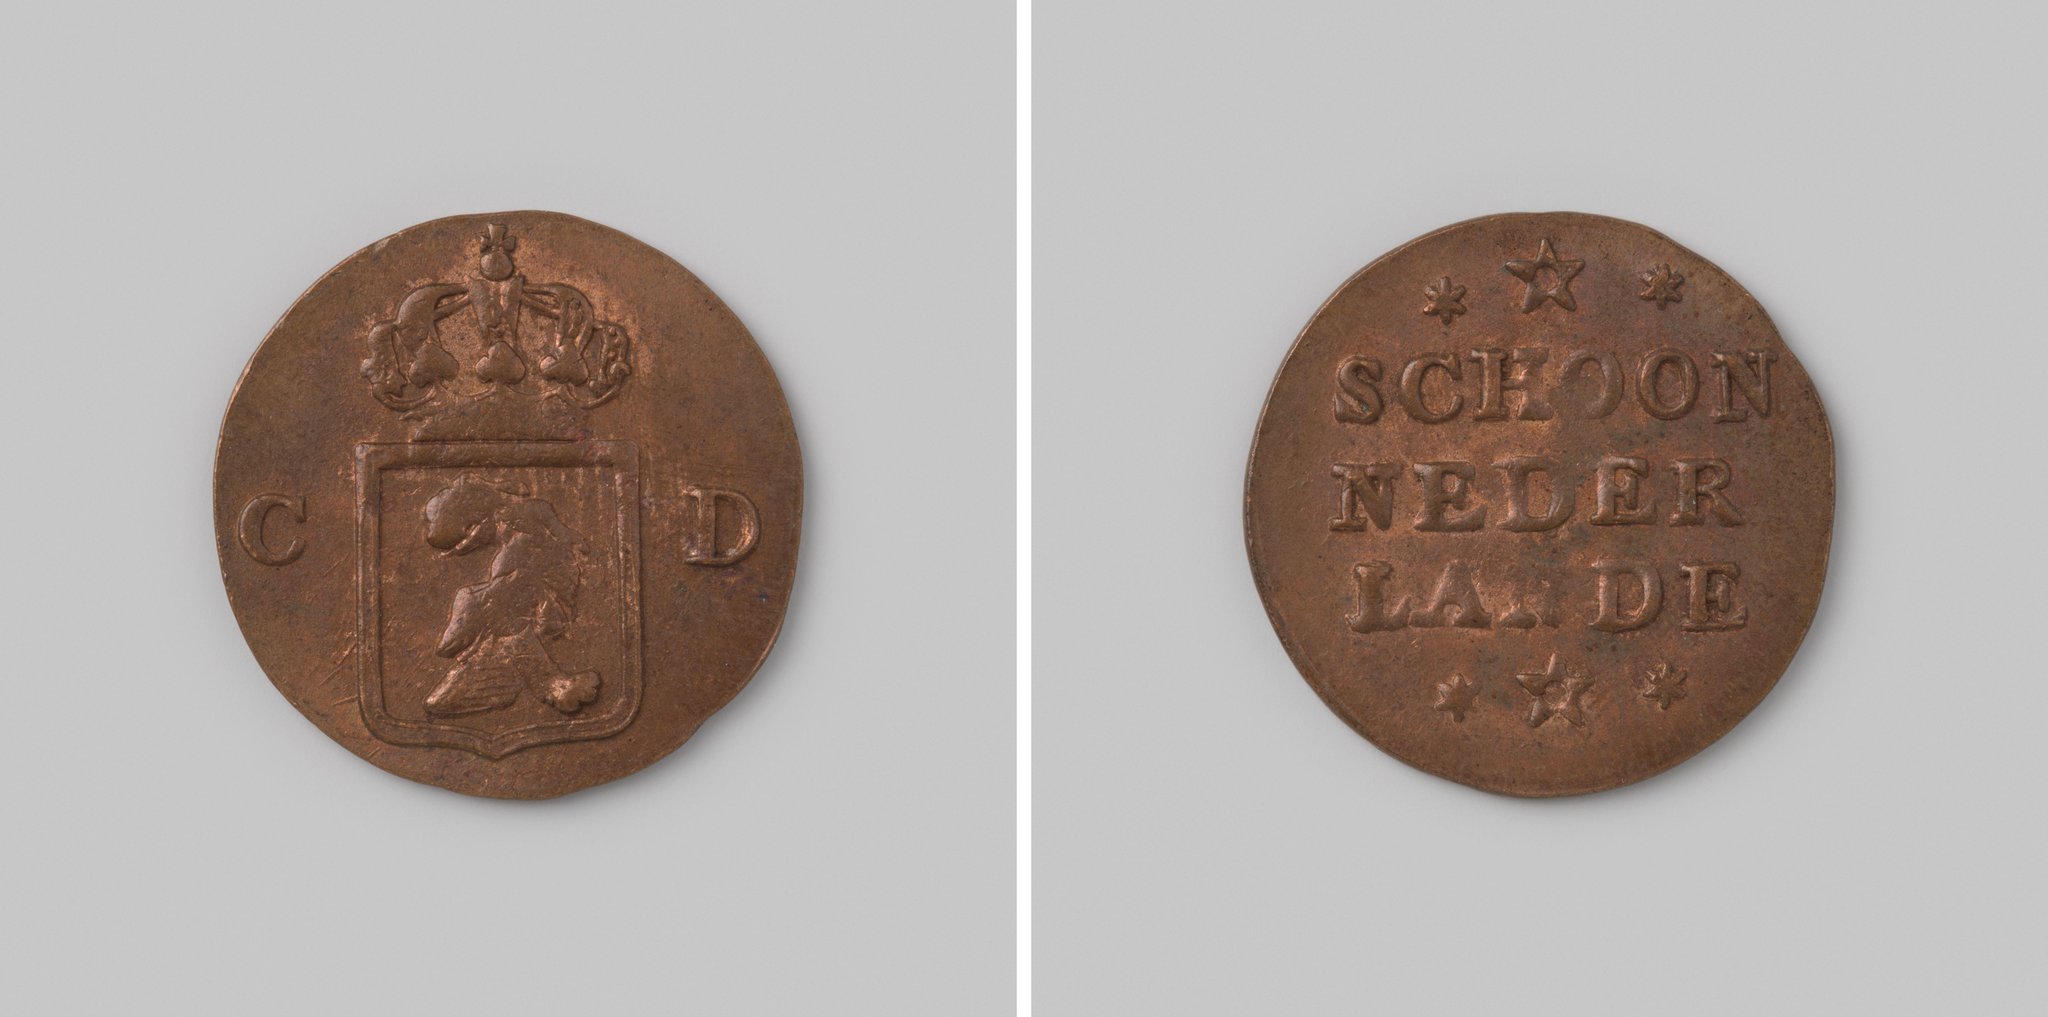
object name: coin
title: Nederlands Indië, leeuwenduit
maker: Anonymous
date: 1836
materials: copper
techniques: striking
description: Koperen proefmunt. Voorzijde: tussen letters C en D gekroond wapenschild, waarin zittende leeuw naar rechts. Keerzijde: drieregelig opschrift, waarboven en waaronder ster. Gladde rand.